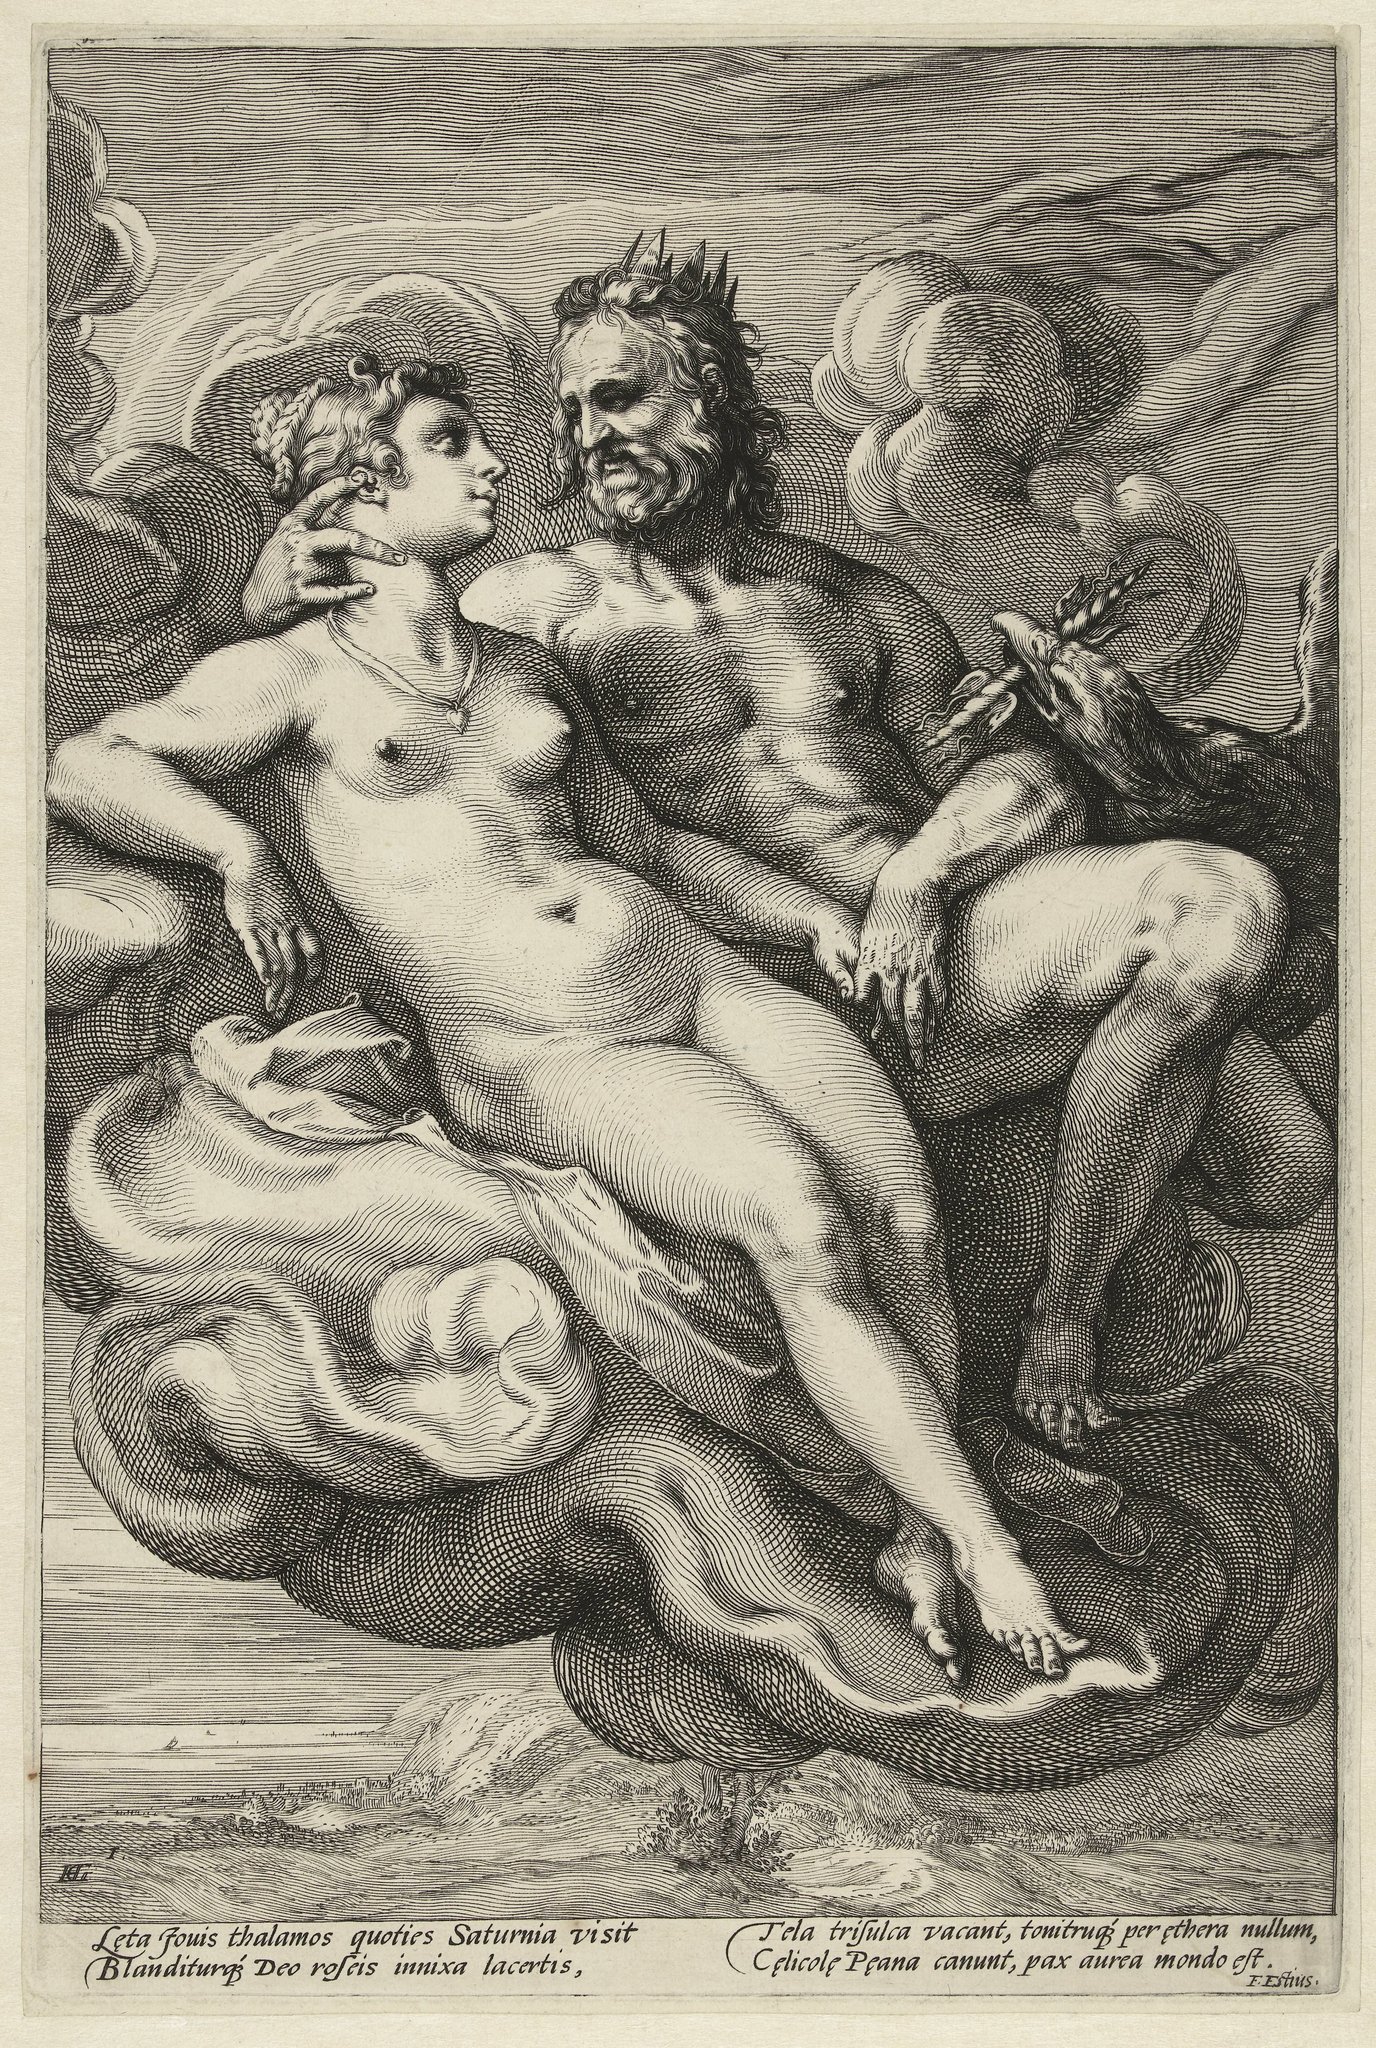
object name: print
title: Jupiter en Juno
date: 1575-1607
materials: paper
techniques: engraving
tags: jupiter and juno as lovers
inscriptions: collector's mark: Lugt 240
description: De naakte Jupiter en Juno samen op een wolk in de lucht. Ze omhelzen elkaar. Aan Jupiters zijde zit de adelaar, de vogel die aan hem is gewijd. Deze houdt een bliksemschicht in zijn snavel, die de heerschappij van Jupiter over het licht symboliseert.De prent is deel van een serie van godenparen en heeft een Latijns onderschrift.